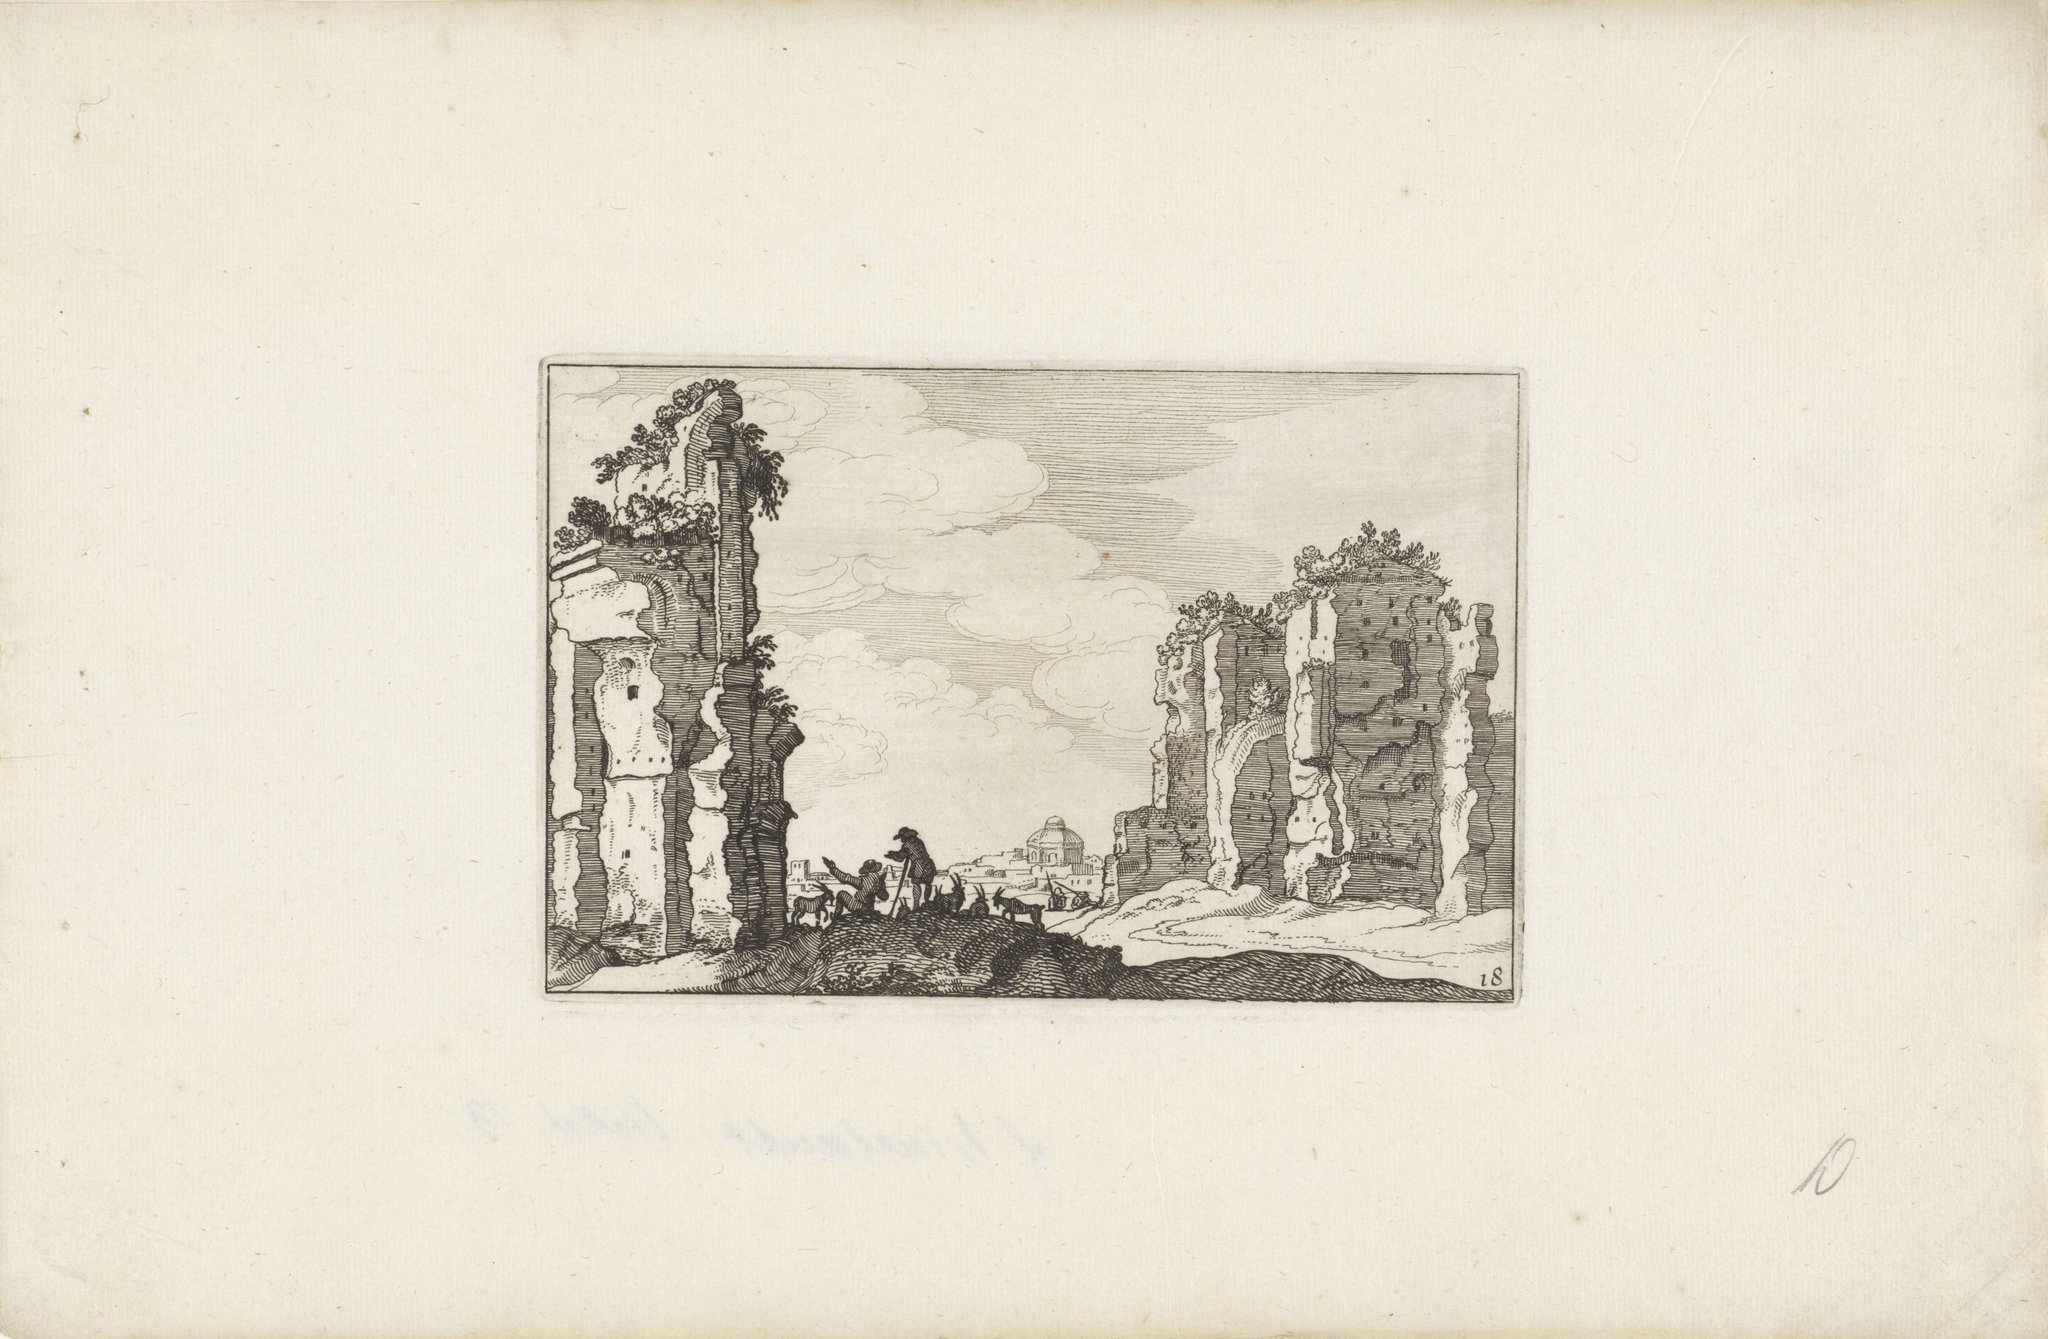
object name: print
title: Twee herders bij een ruïne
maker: claes jansz. visscher (ii)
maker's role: draughtsman, print maker, publisher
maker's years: 1586-1652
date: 1618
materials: paper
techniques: etching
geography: amsterdam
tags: herding, herdsman, herdswoman, shepherd, shepherdess, cowherd, etc., landscape with ruins, goat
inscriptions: collector's mark: Lugt 2233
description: Gezicht op een glooiend landschap met twee herders die een gesprek voeren bij een ruïneus gebouw. Om hen heen staat geiten. Een van de herders wijst op de ruïne. Op de achtergrond ruïnes en een stad.